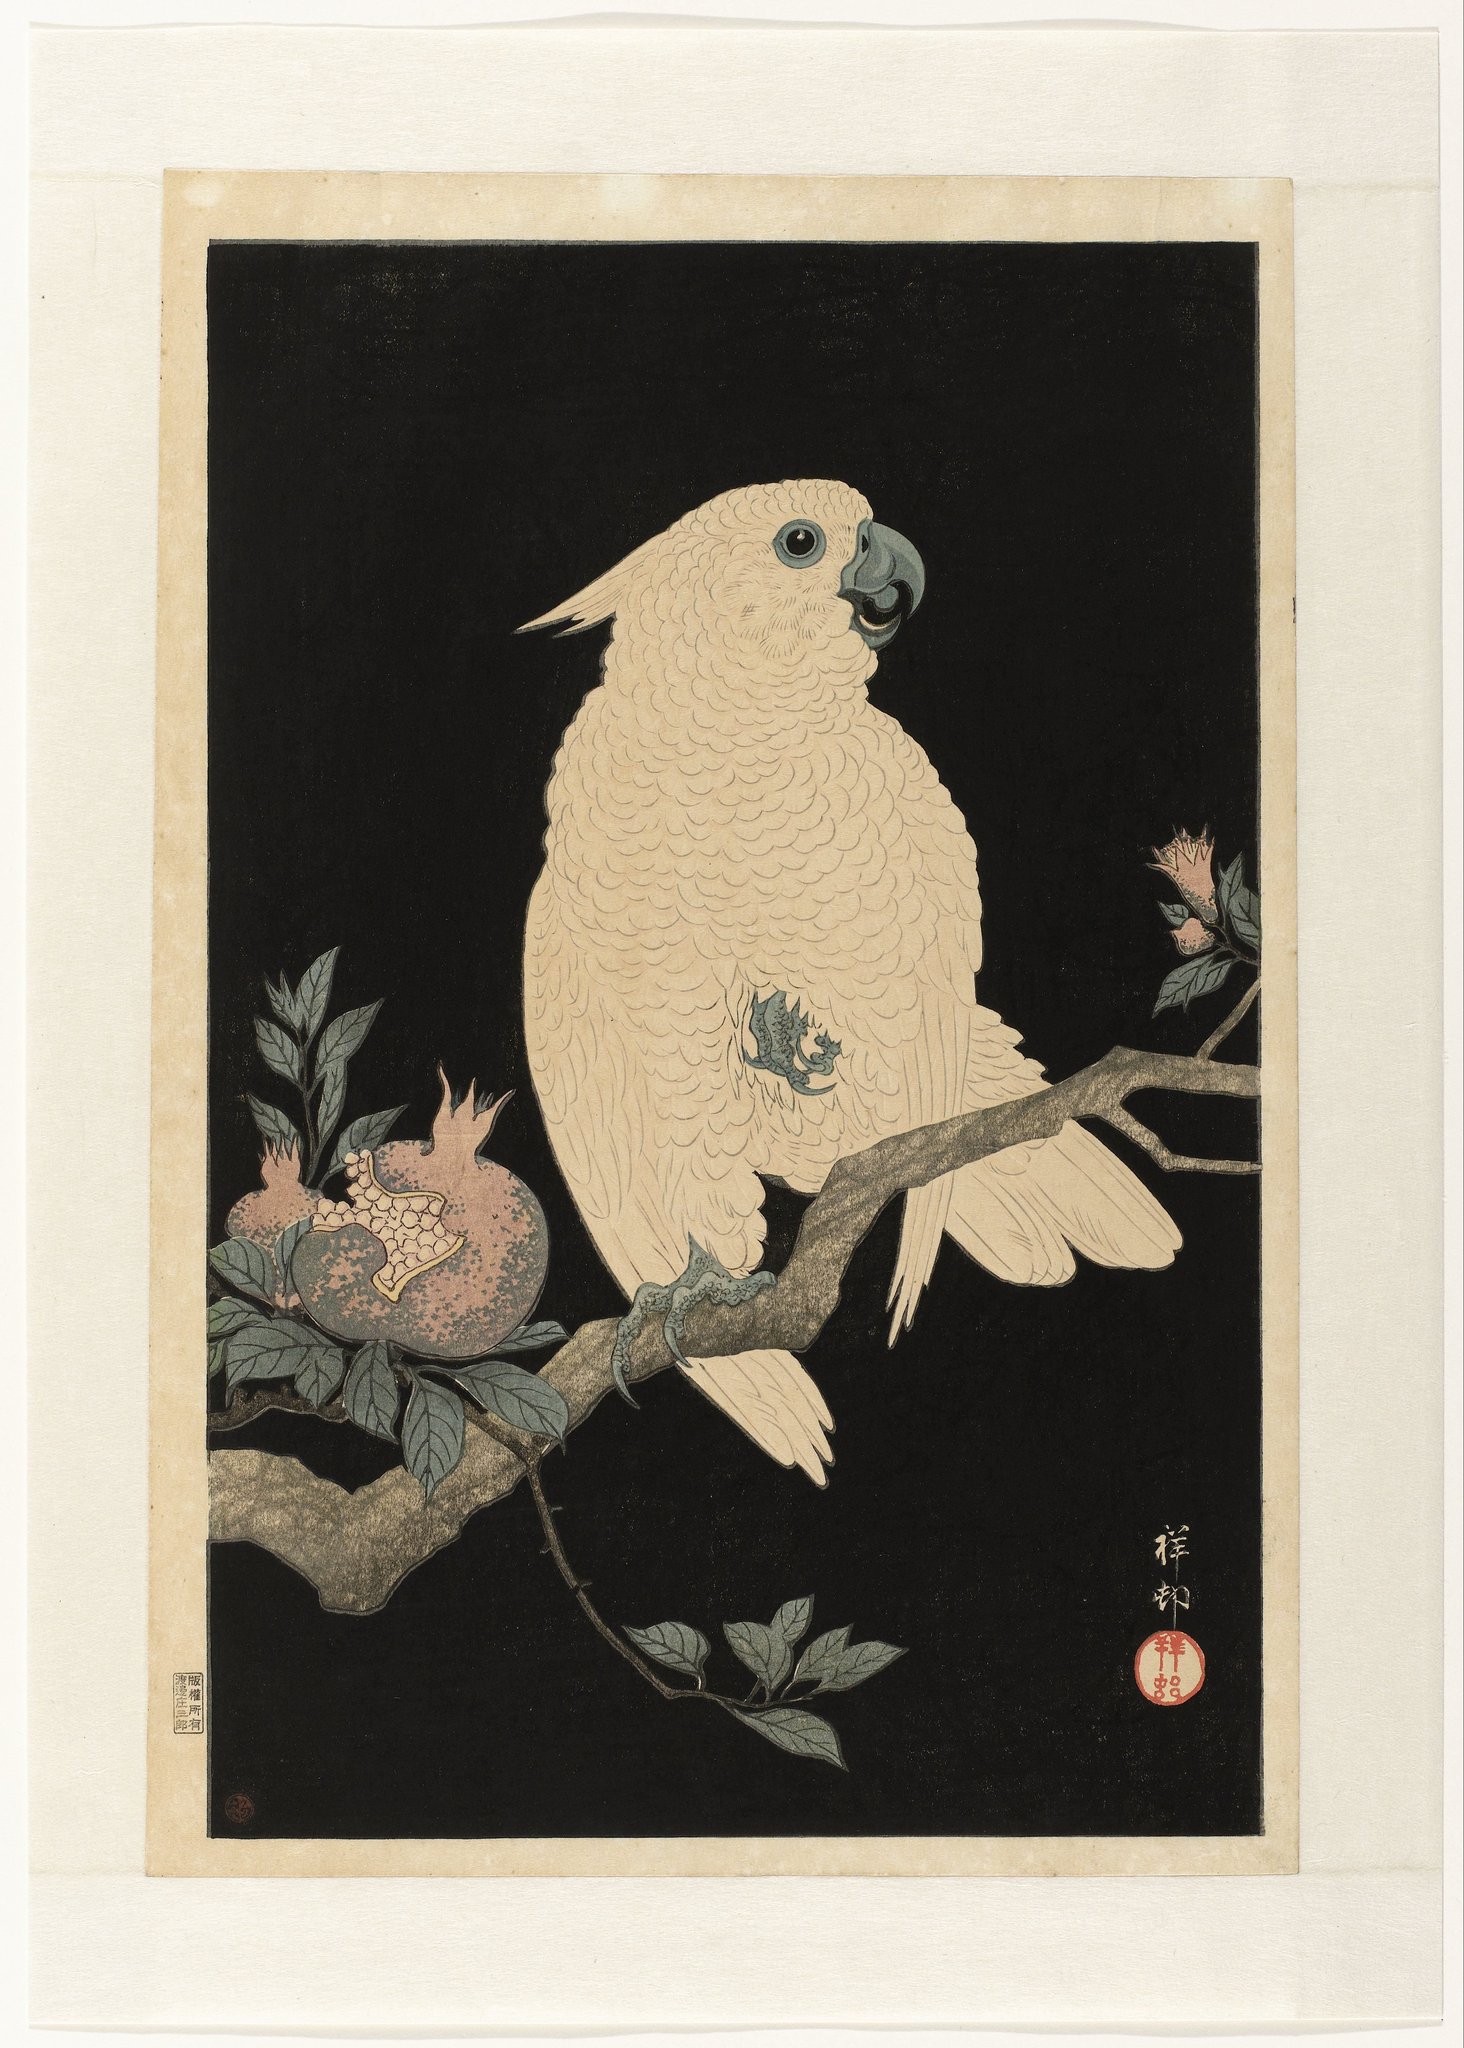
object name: print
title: Kaketoe met granaatappel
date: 1927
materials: paper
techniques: blind stamped, woodcut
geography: japan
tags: ornamental birds: cockatoo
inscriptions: collector's mark: Lugt 2228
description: Een witte kaketoe zittend op een tak naast een granaatappel.